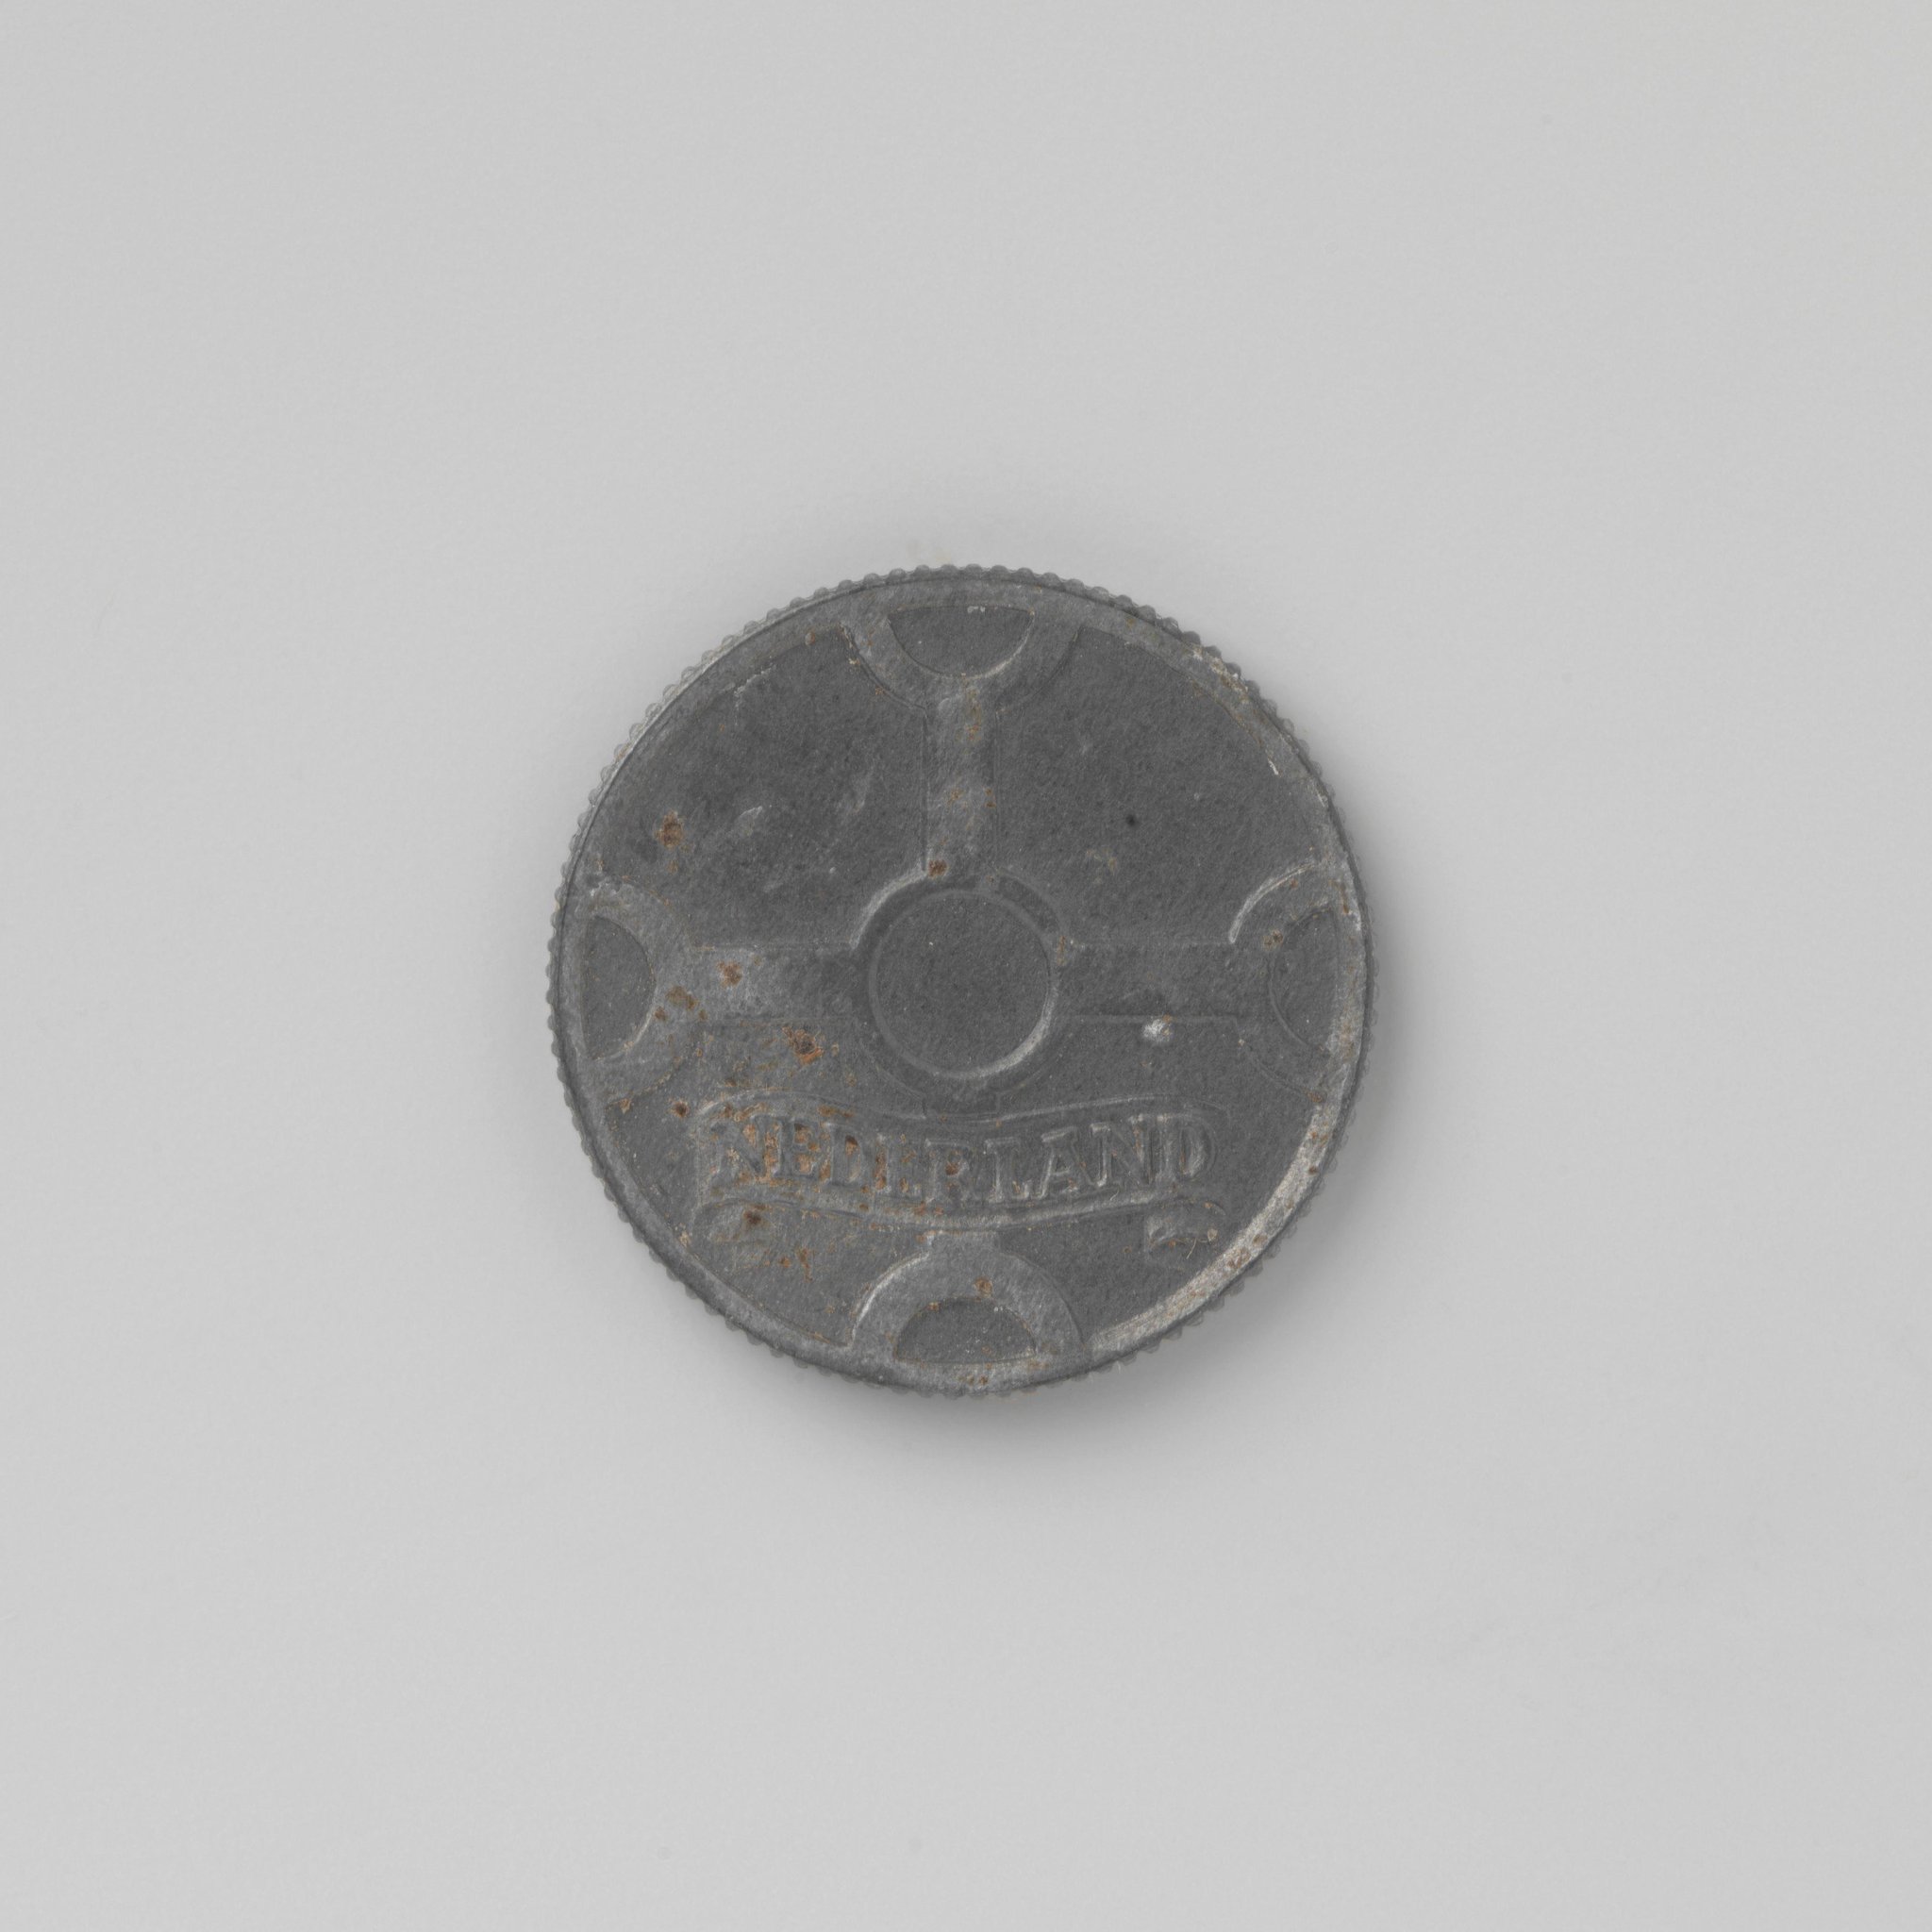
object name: coin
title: Nederlandse cent,1943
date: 1943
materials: zinc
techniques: striking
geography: utrecht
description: Zinken munt. Voorzijde: rechtkruis. Keerzijde: waarde-aanduiding 1 ct, rechts vier golven en een korenaar. daaronder op een band jaartal. Kartelrand.